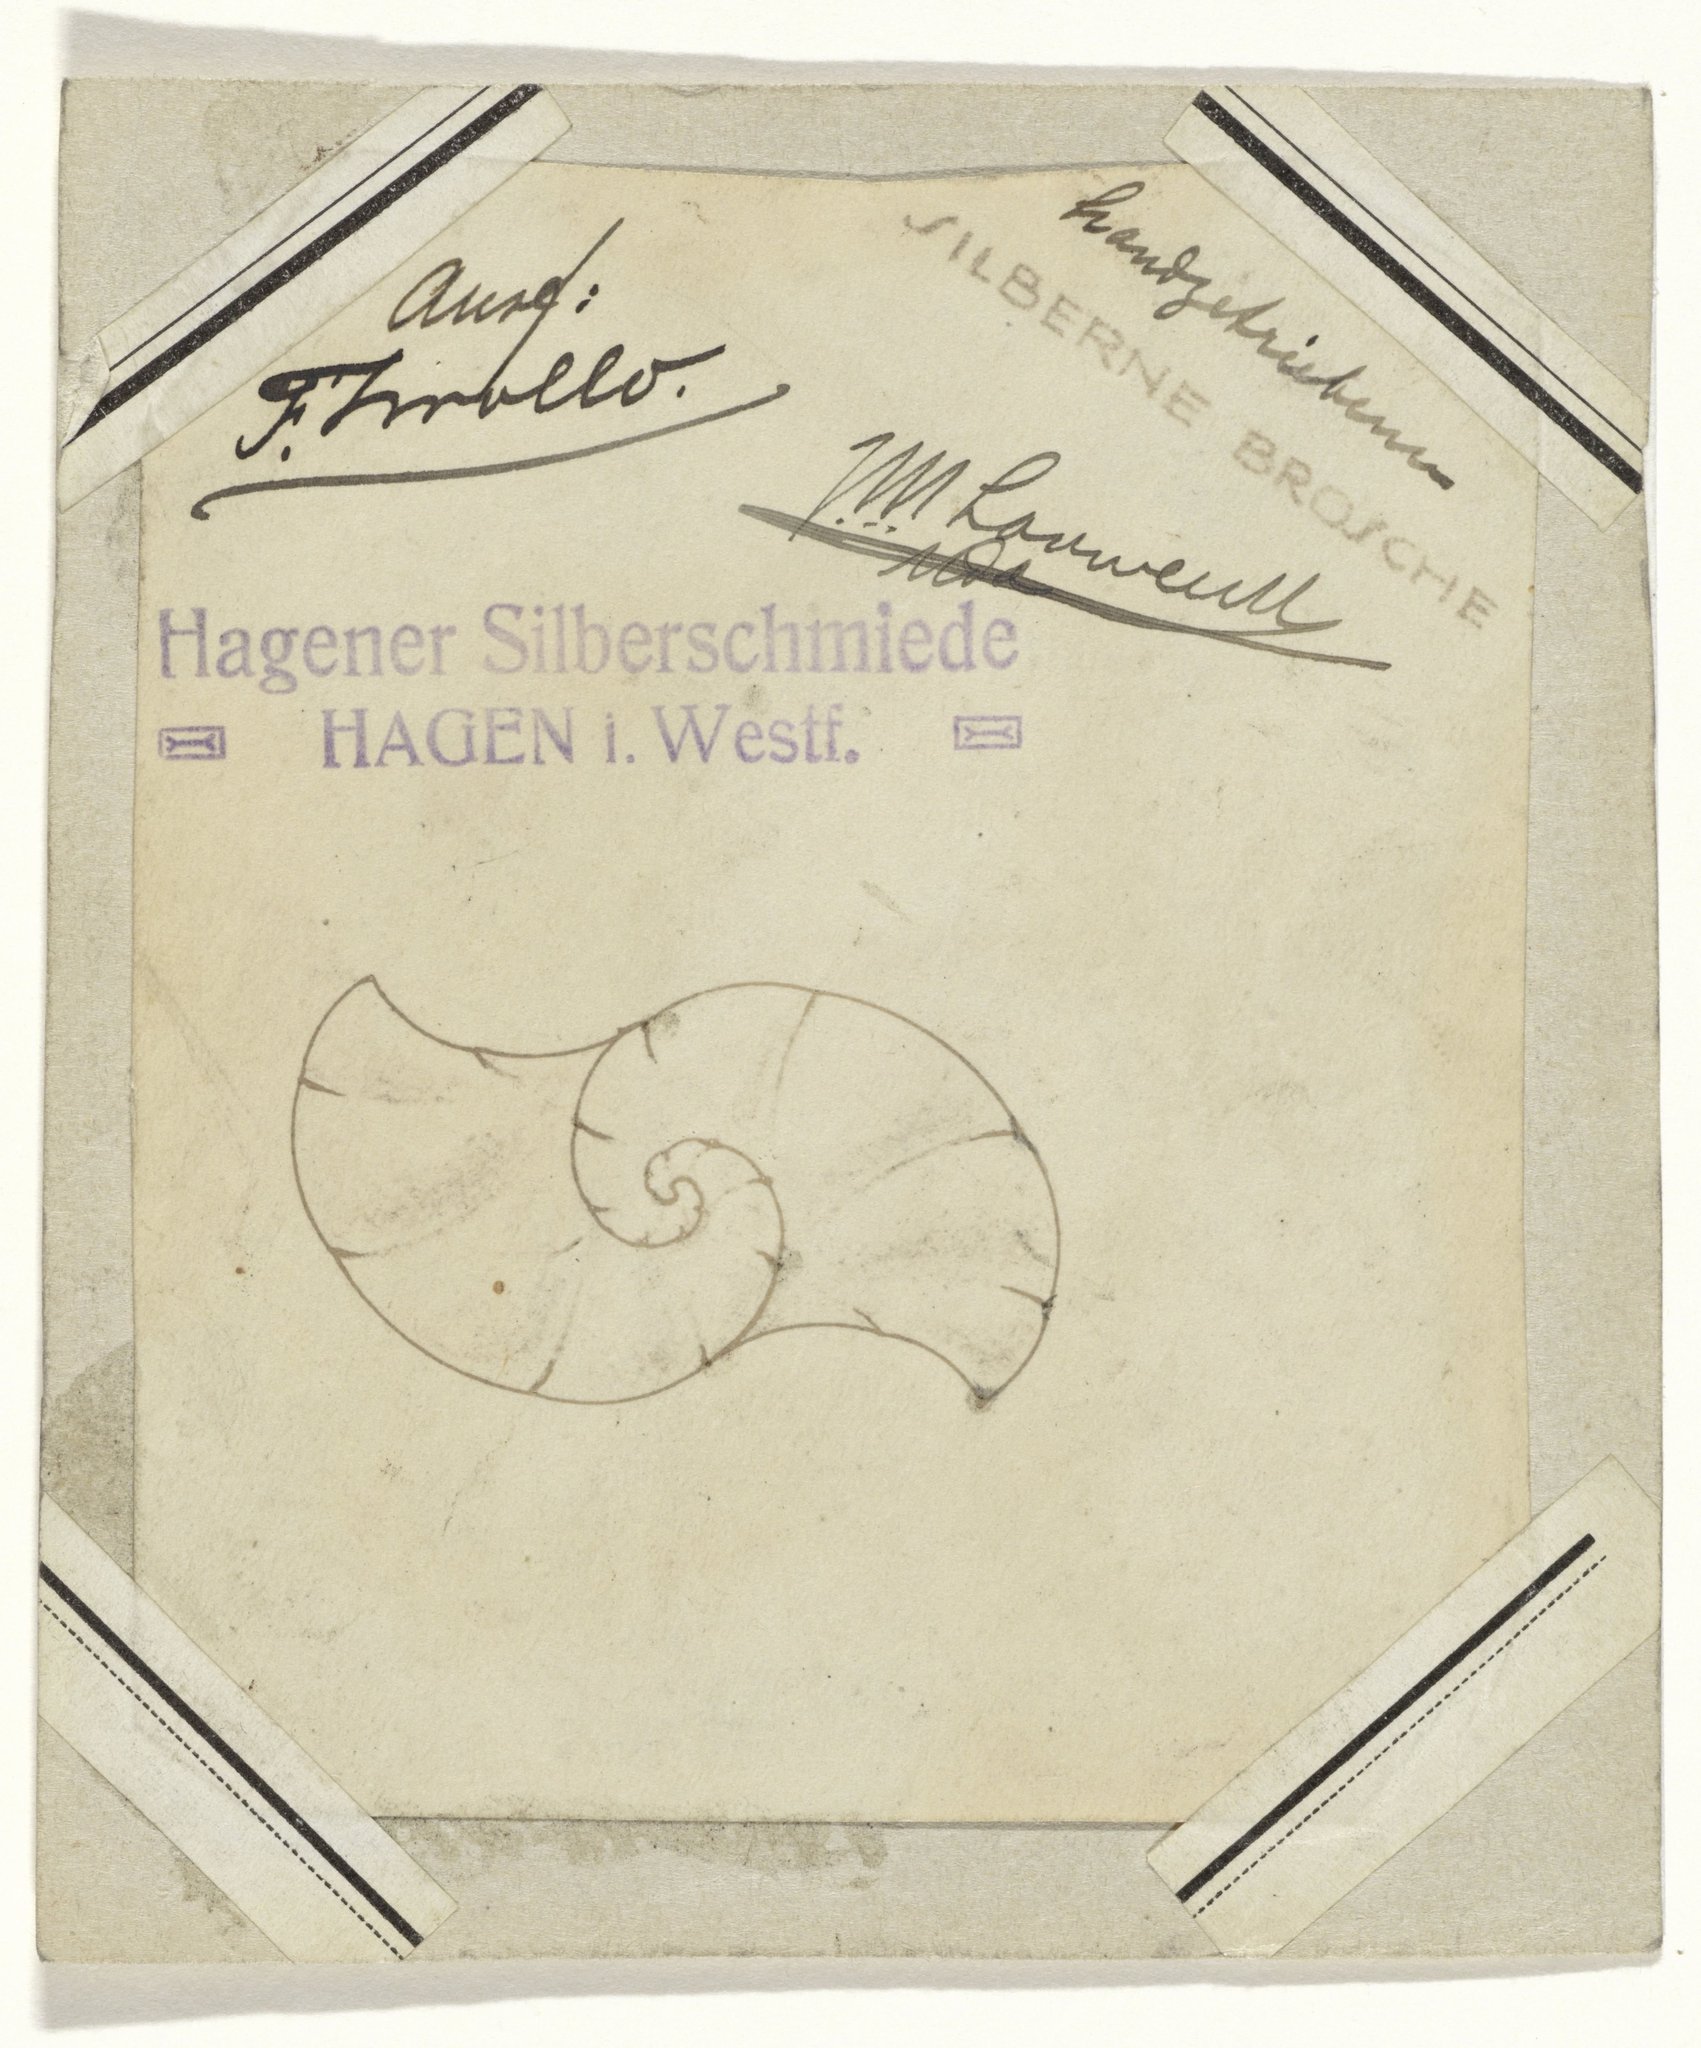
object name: drawing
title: Ontwerpen voor een zilveren broche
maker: mathieu lauweriks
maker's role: designer, draughtsman, print maker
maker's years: 1864-1932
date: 1874-1932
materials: ink, paper, pencil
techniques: pen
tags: brooch, agraffe, clasp